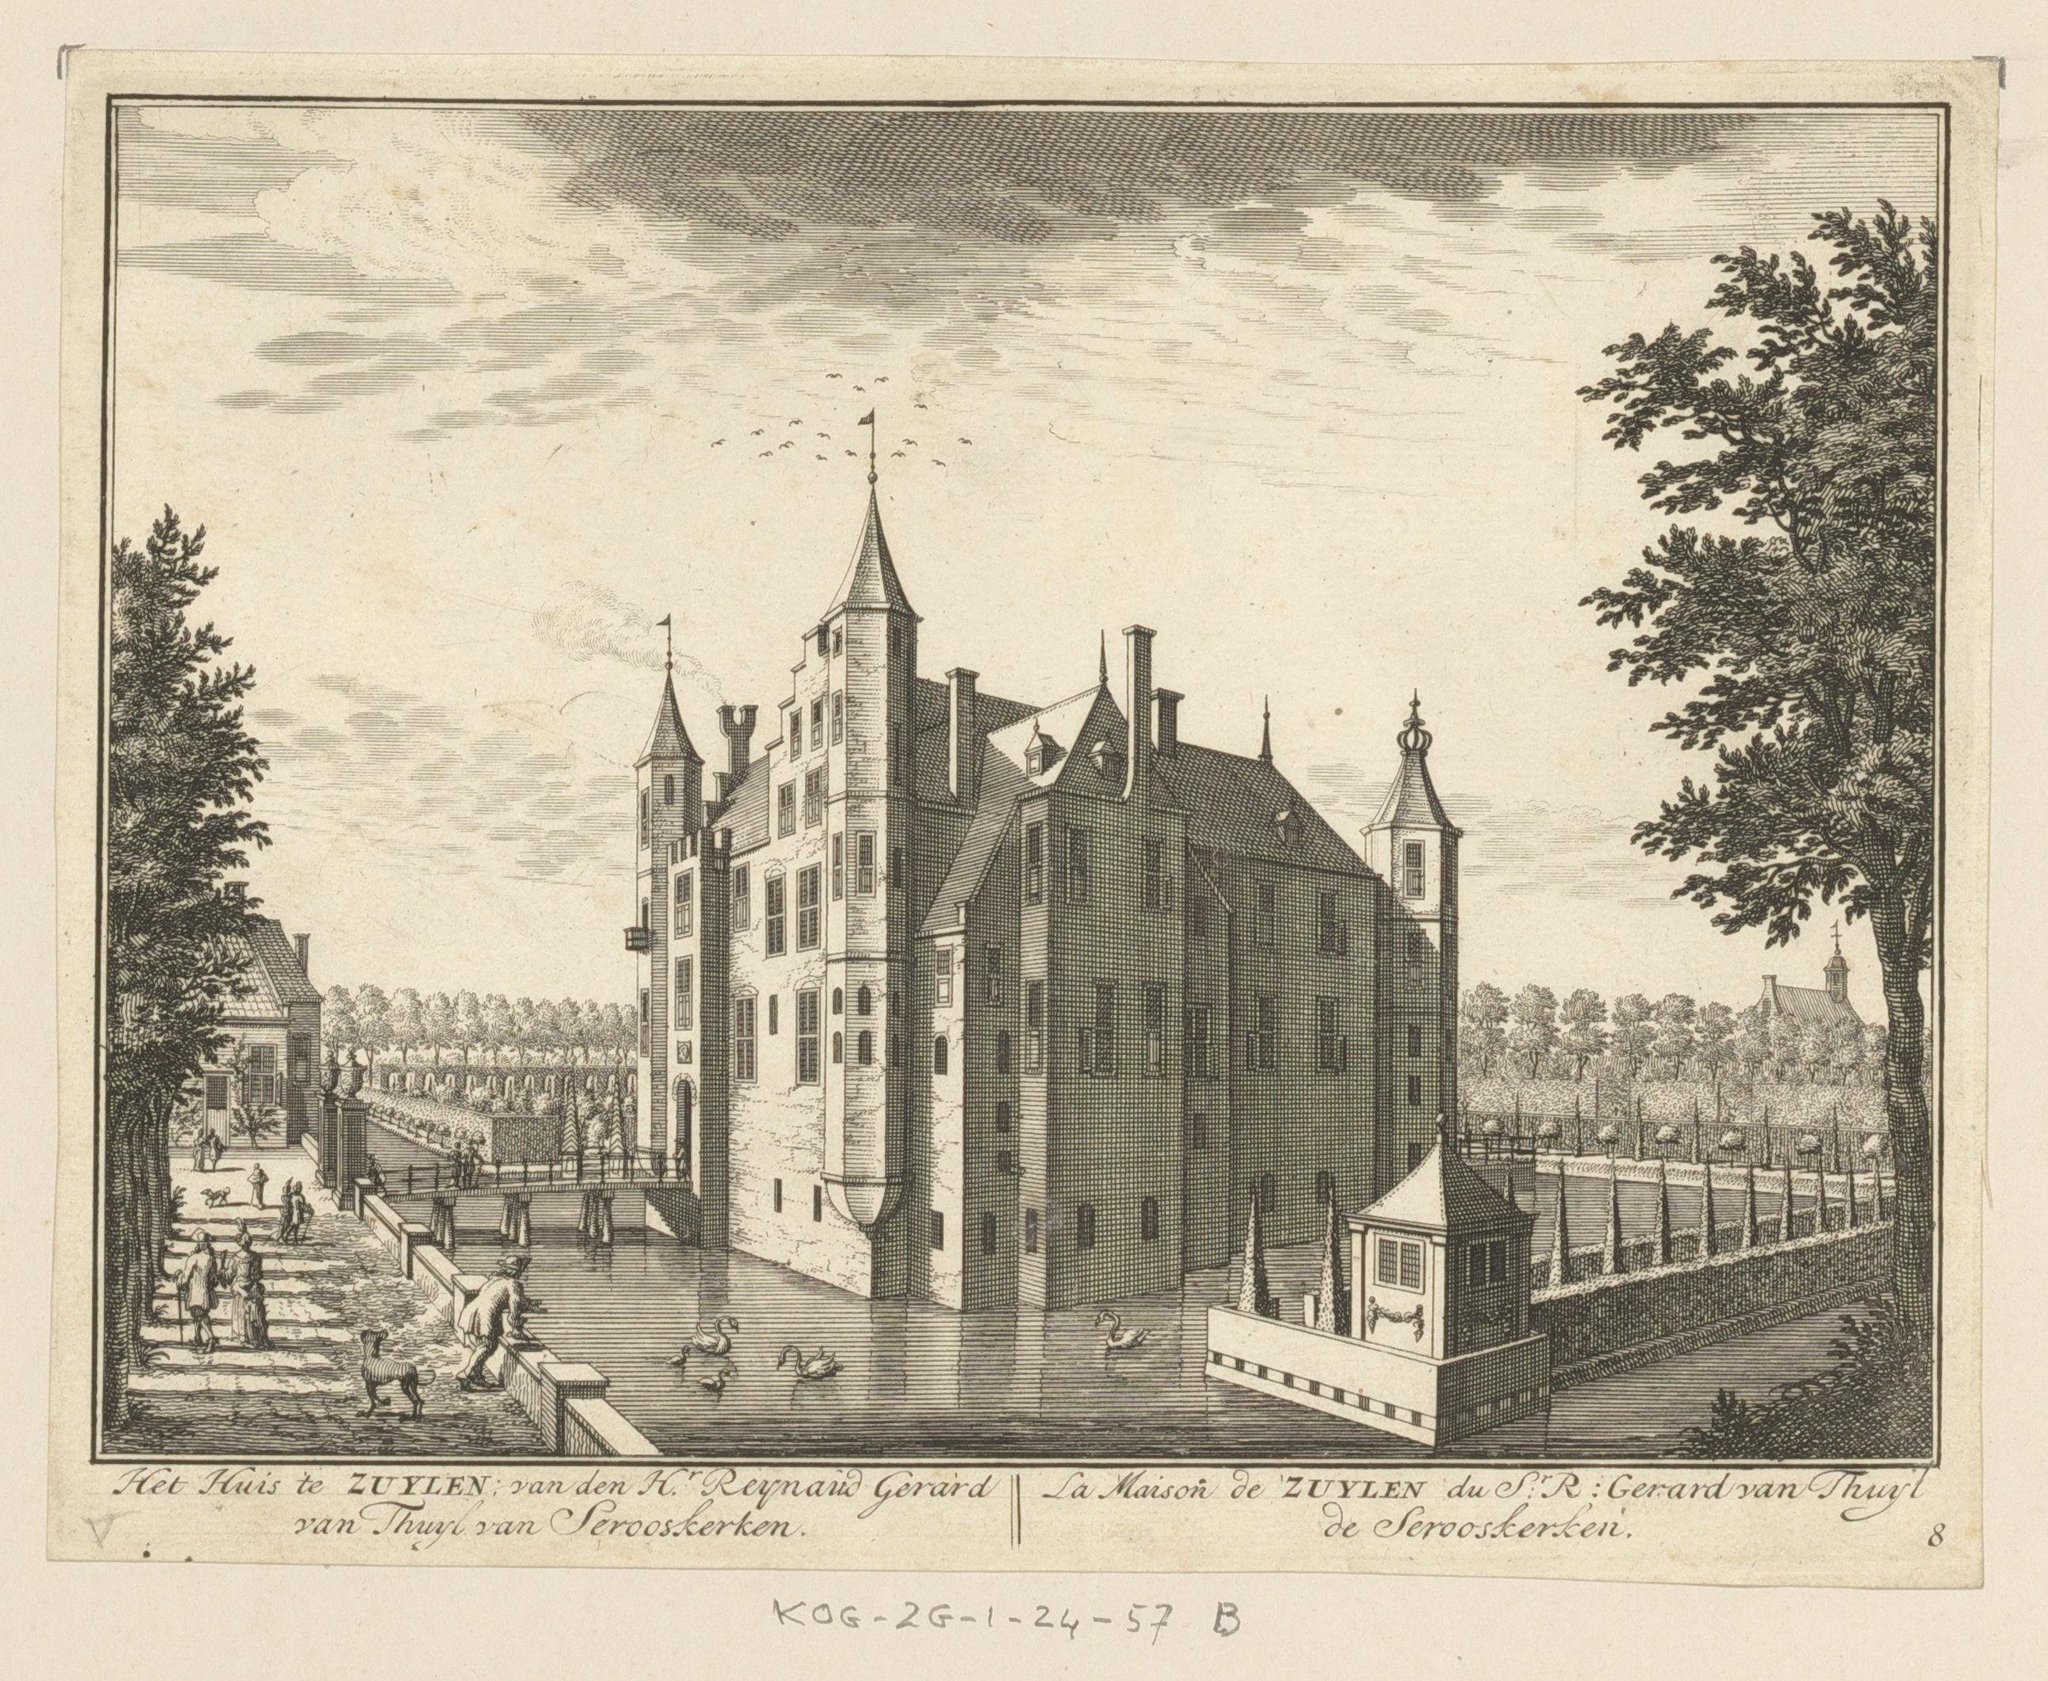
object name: book illustration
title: Het Huis te Zuylen; van den H. Reynaud Gerard van Thurl van Serooskerken / La Maison de Zuylen de S. R. : Gerard van Thuyl de Serooskerke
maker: daniël stopendaal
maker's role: print maker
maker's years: 1672-1726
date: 1719-1790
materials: paper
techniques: engraving, etching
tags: rural housing, e.g. country-house, villa, cottage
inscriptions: stamp, stamp, collector's mark: Lugt 1641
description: Prent mogelijk uit: Leth, Andries de. De zegepraalende Vecht, vertoonende verscheidene gesichten van lustplaatsen, heeren huysen en dorpen, beginnende van Uitrecht en met Muyden besluytende (...). Amsterdam: Weduwe Nicolaus Visscher, 1719. Of uit: Brouërius van Nidek, Matthaeus. De Vechtstroom, van Utrecht tot Muiden (...). Amsterdam: H. Gartman, W. Vermandel en J.W. Smit, 1790.